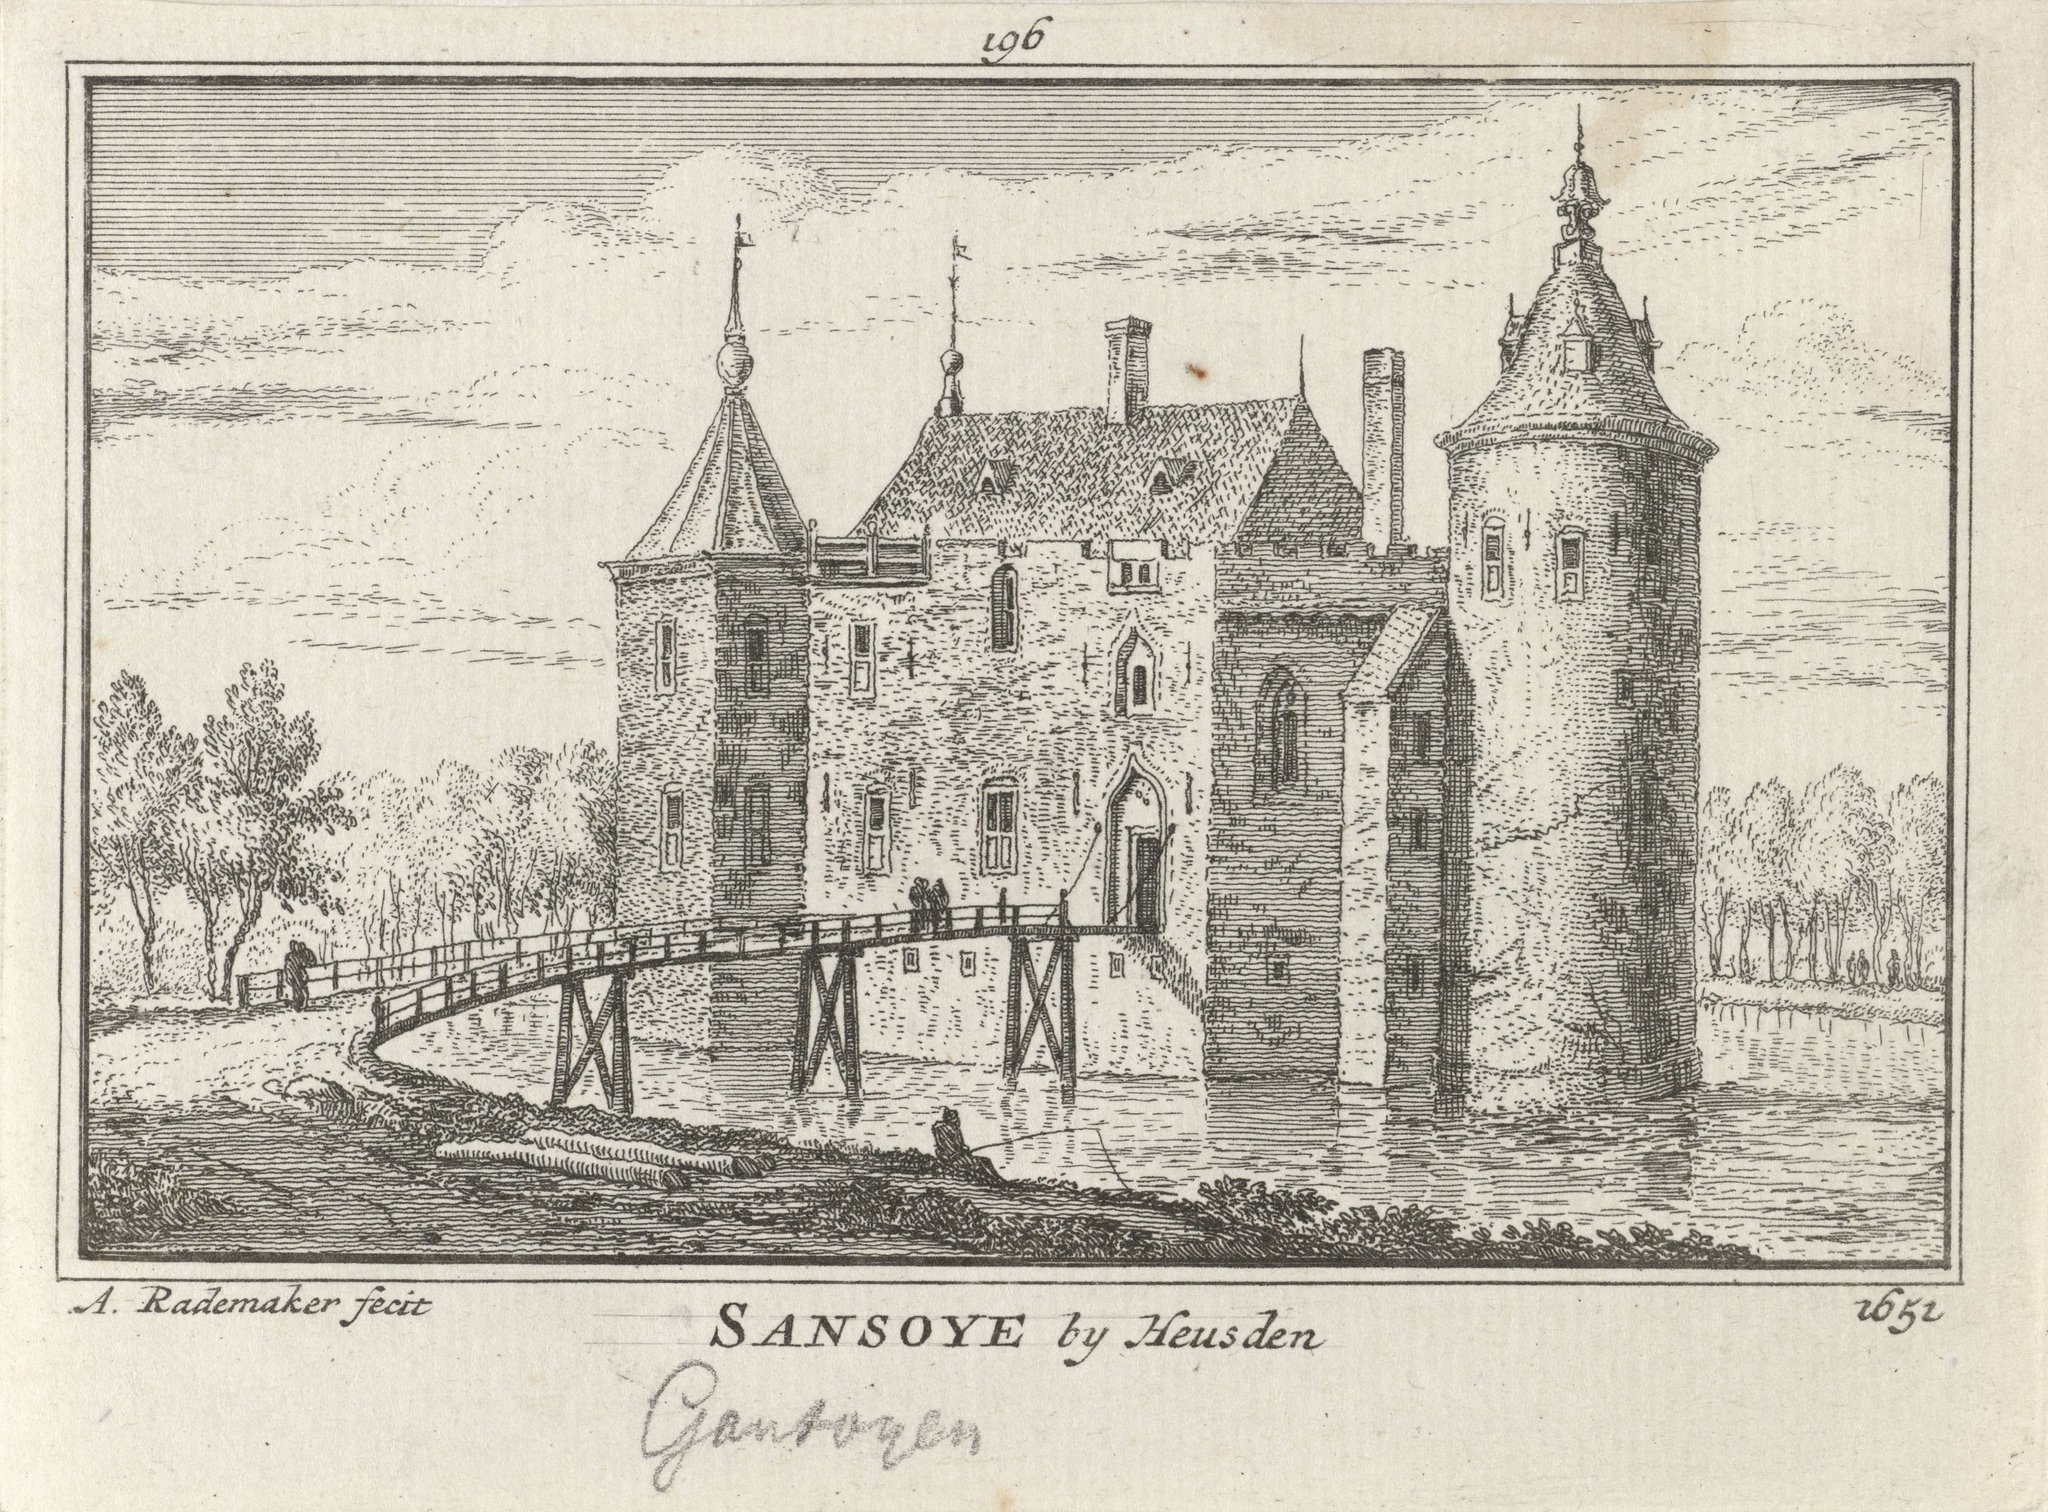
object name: print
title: Gezicht op Kasteel Gansoijen, 1652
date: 1727-1733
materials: paper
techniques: etching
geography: amsterdam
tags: castle, bridge, fisherman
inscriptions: collector's mark: Lugt 2228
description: Illustratie uit: Abraham Rademaker, Matthaeus Brouërius van Niedek, Isaac Le Long, Kabinet van Nederlandsche en Kleefsche outheden en (...) voorname stads- en landgebouwen, Willem Barents en Antoni Schoonenburg: Amsterdam, 1727-1733, ill. nr. 196.